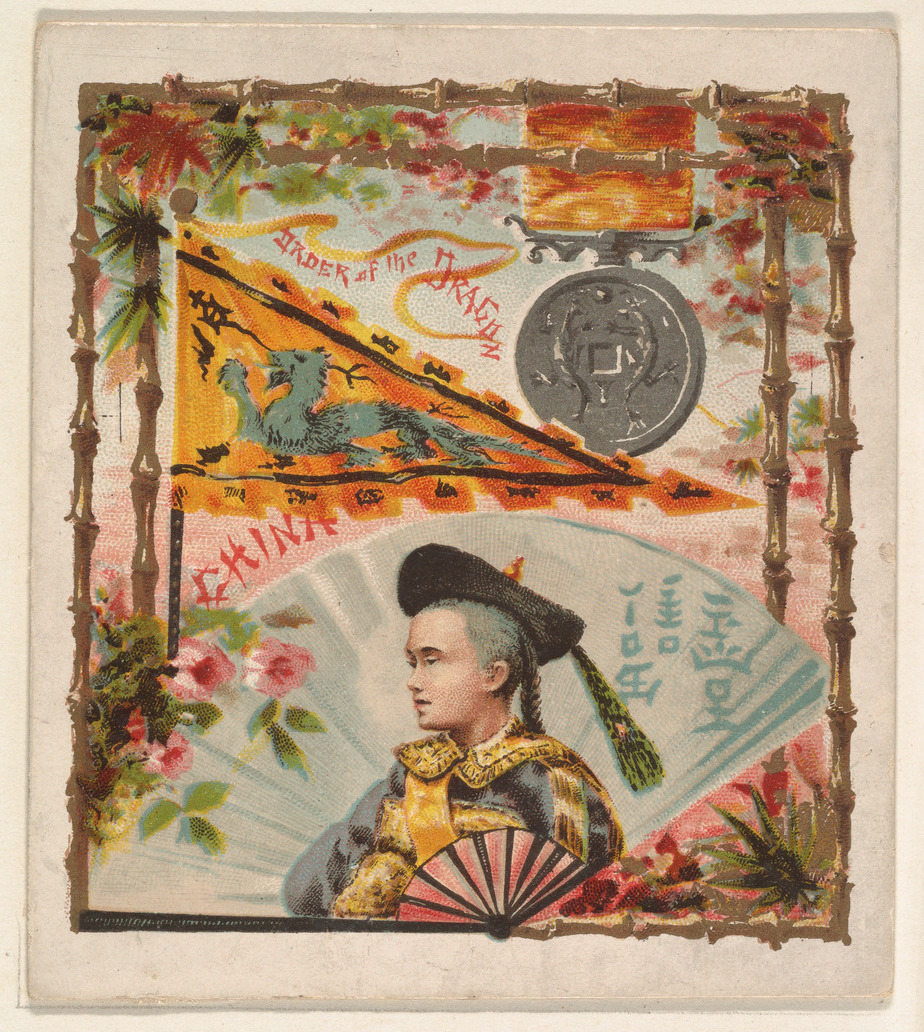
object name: print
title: China, from the International Cards series (N238), issued by Kinney Bros.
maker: kinney brothers tobacco company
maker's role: publisher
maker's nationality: american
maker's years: 1869-2011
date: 1888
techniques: color lithograph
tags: men,dragons,flags